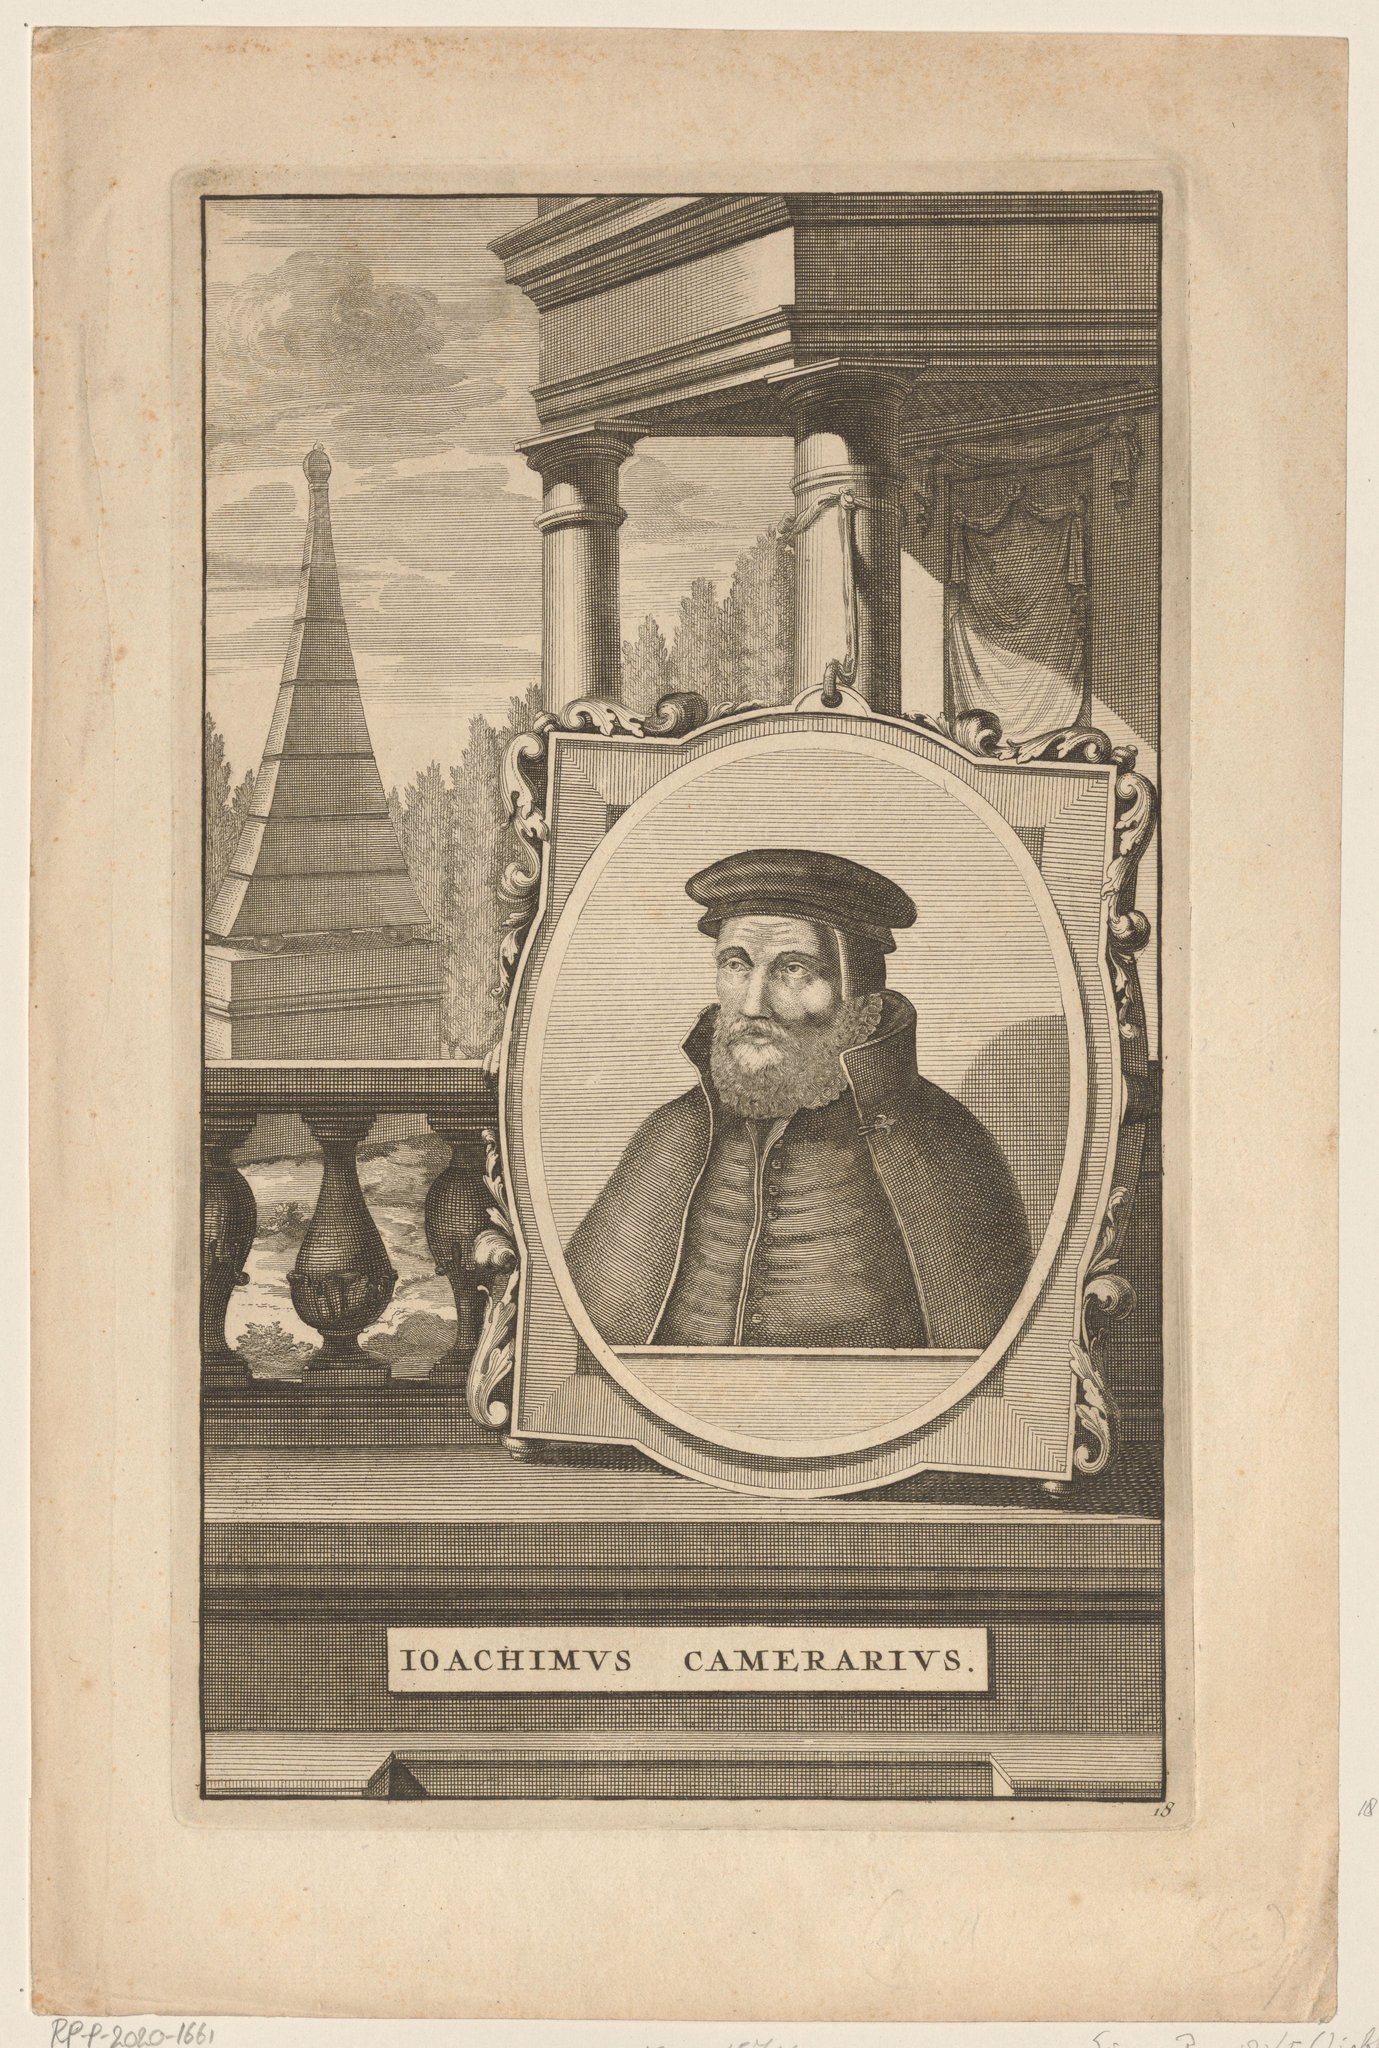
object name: print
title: Portret van Joachim Camerarius I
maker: Anonymous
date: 1600-1699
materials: paper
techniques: etching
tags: joachim camerarius (i), historical persons